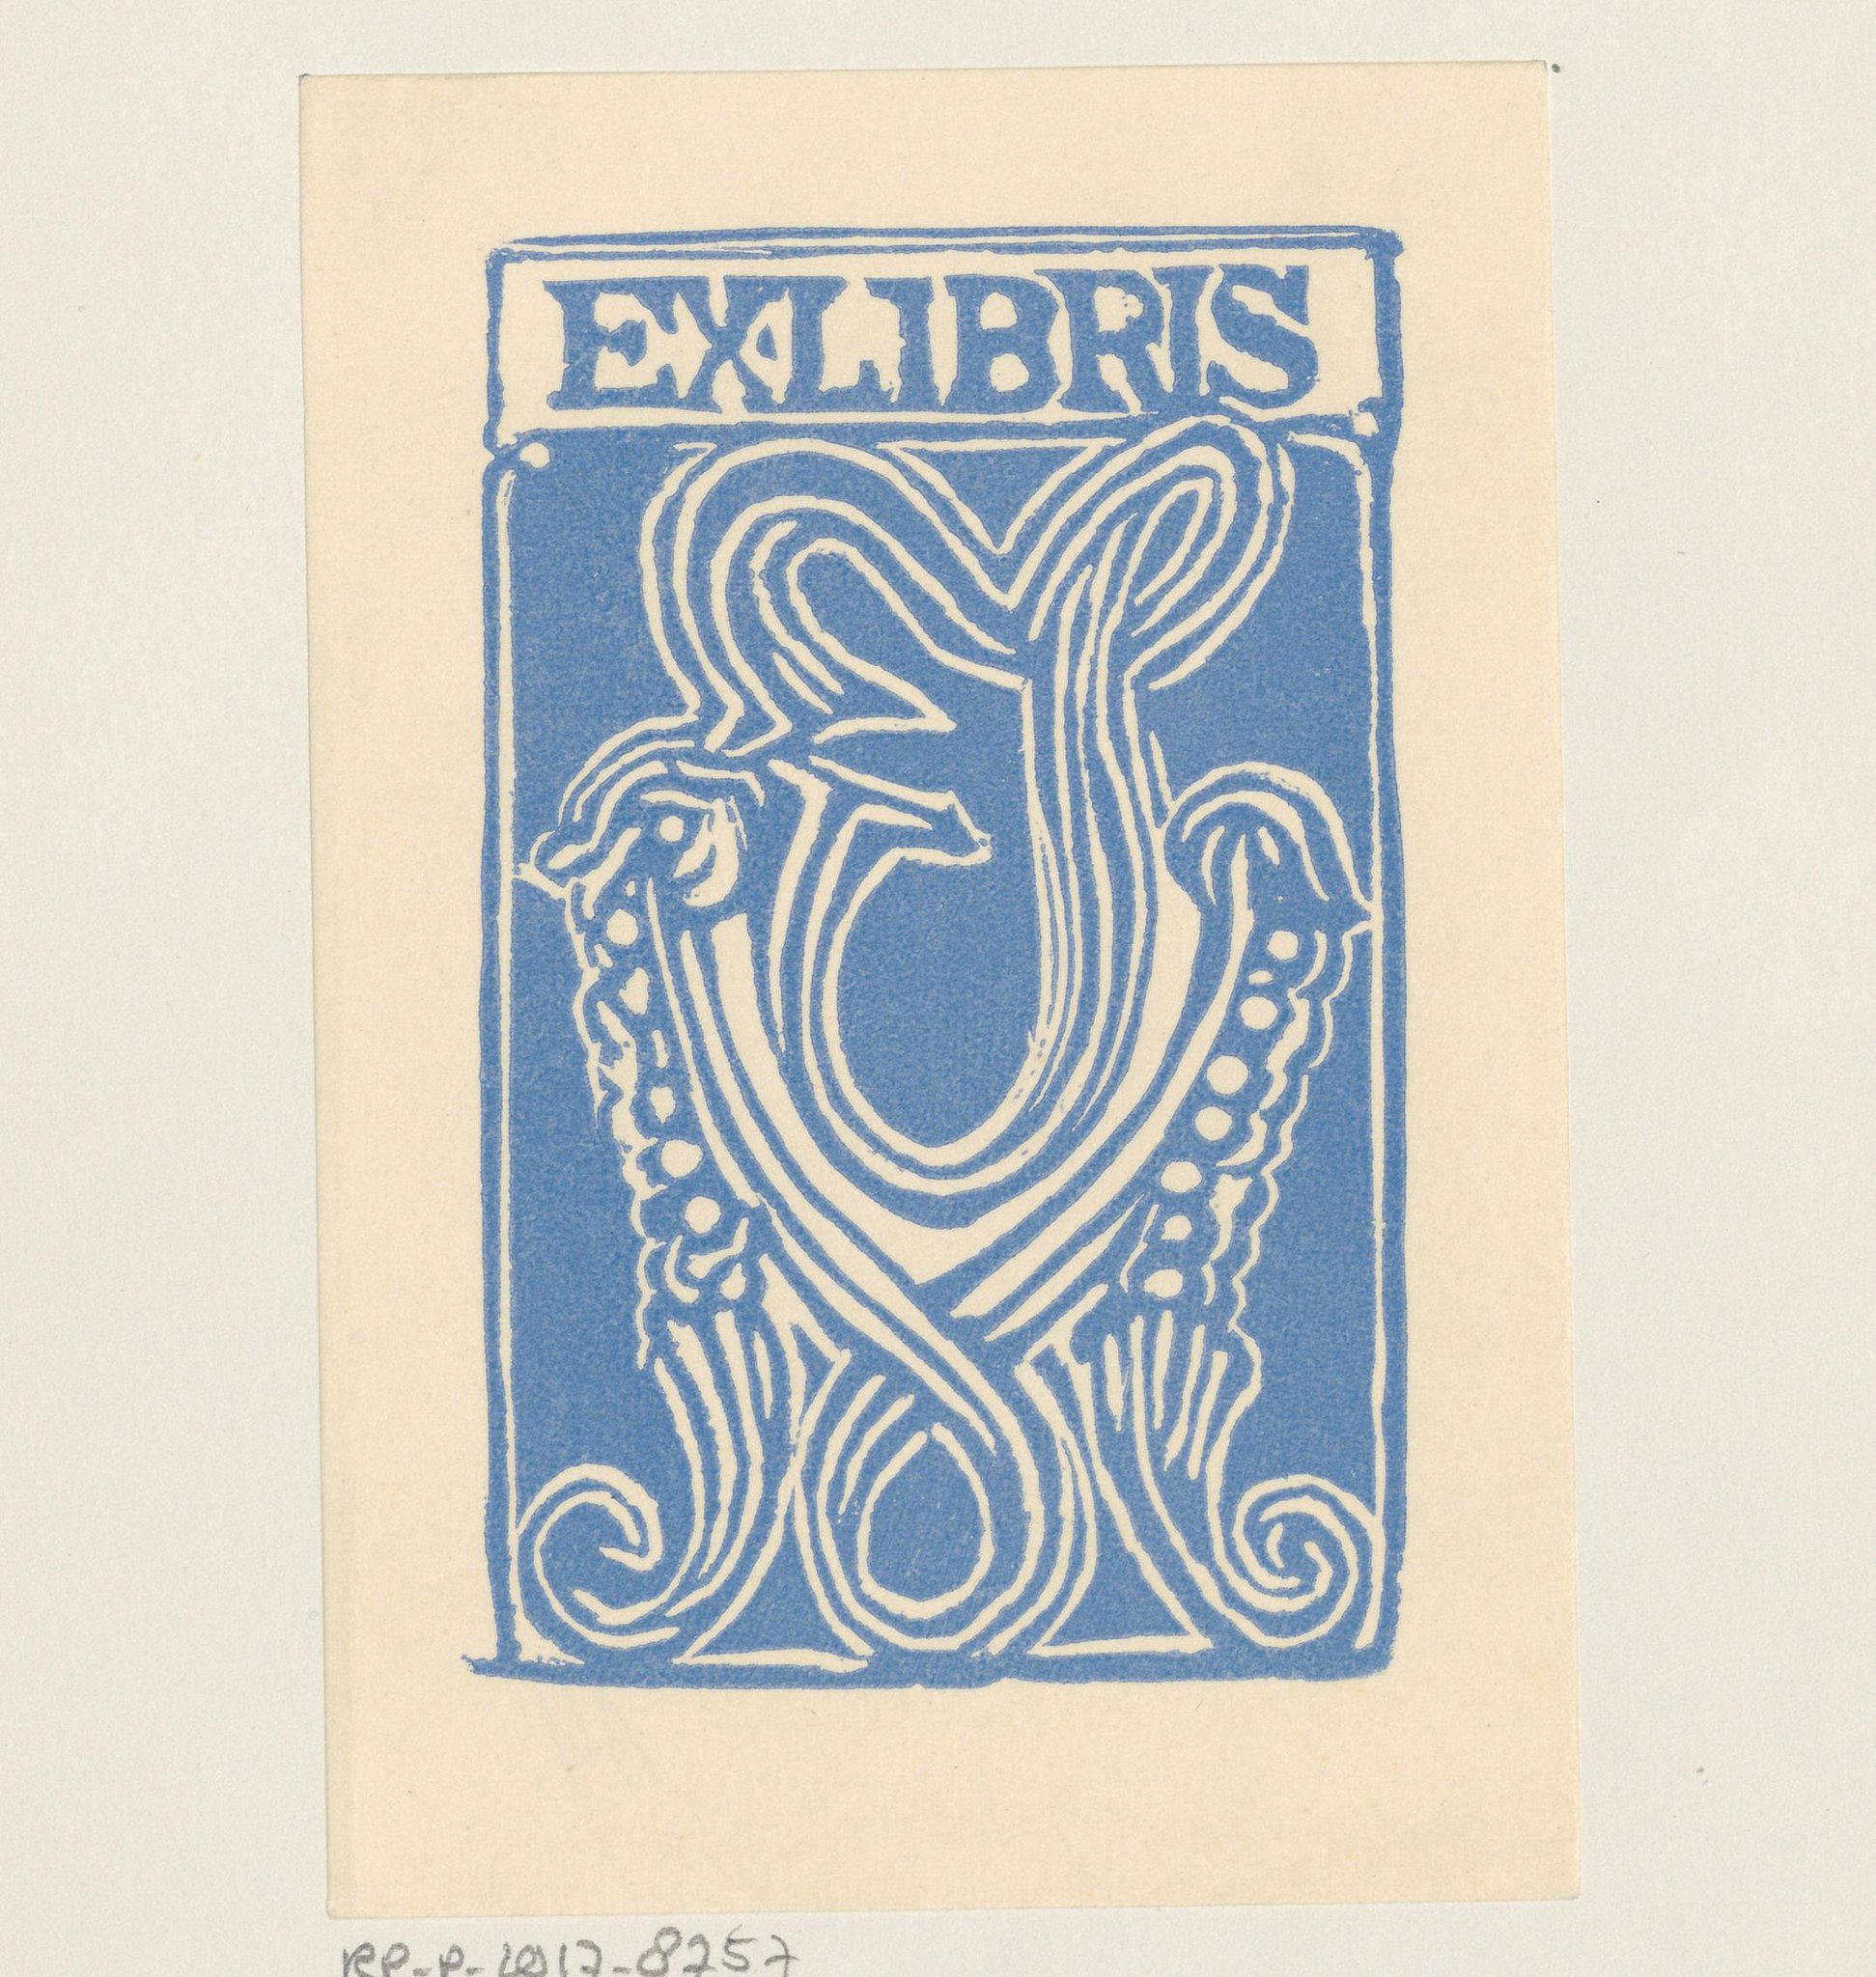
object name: bookplate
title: Ex libris J.M.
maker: slavoby tusar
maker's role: print maker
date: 1945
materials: paper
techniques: woodcut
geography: czech republic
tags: maira jančáková (máňa)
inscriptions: inscription: ‘Slavoby Tusar, dř. 1945’